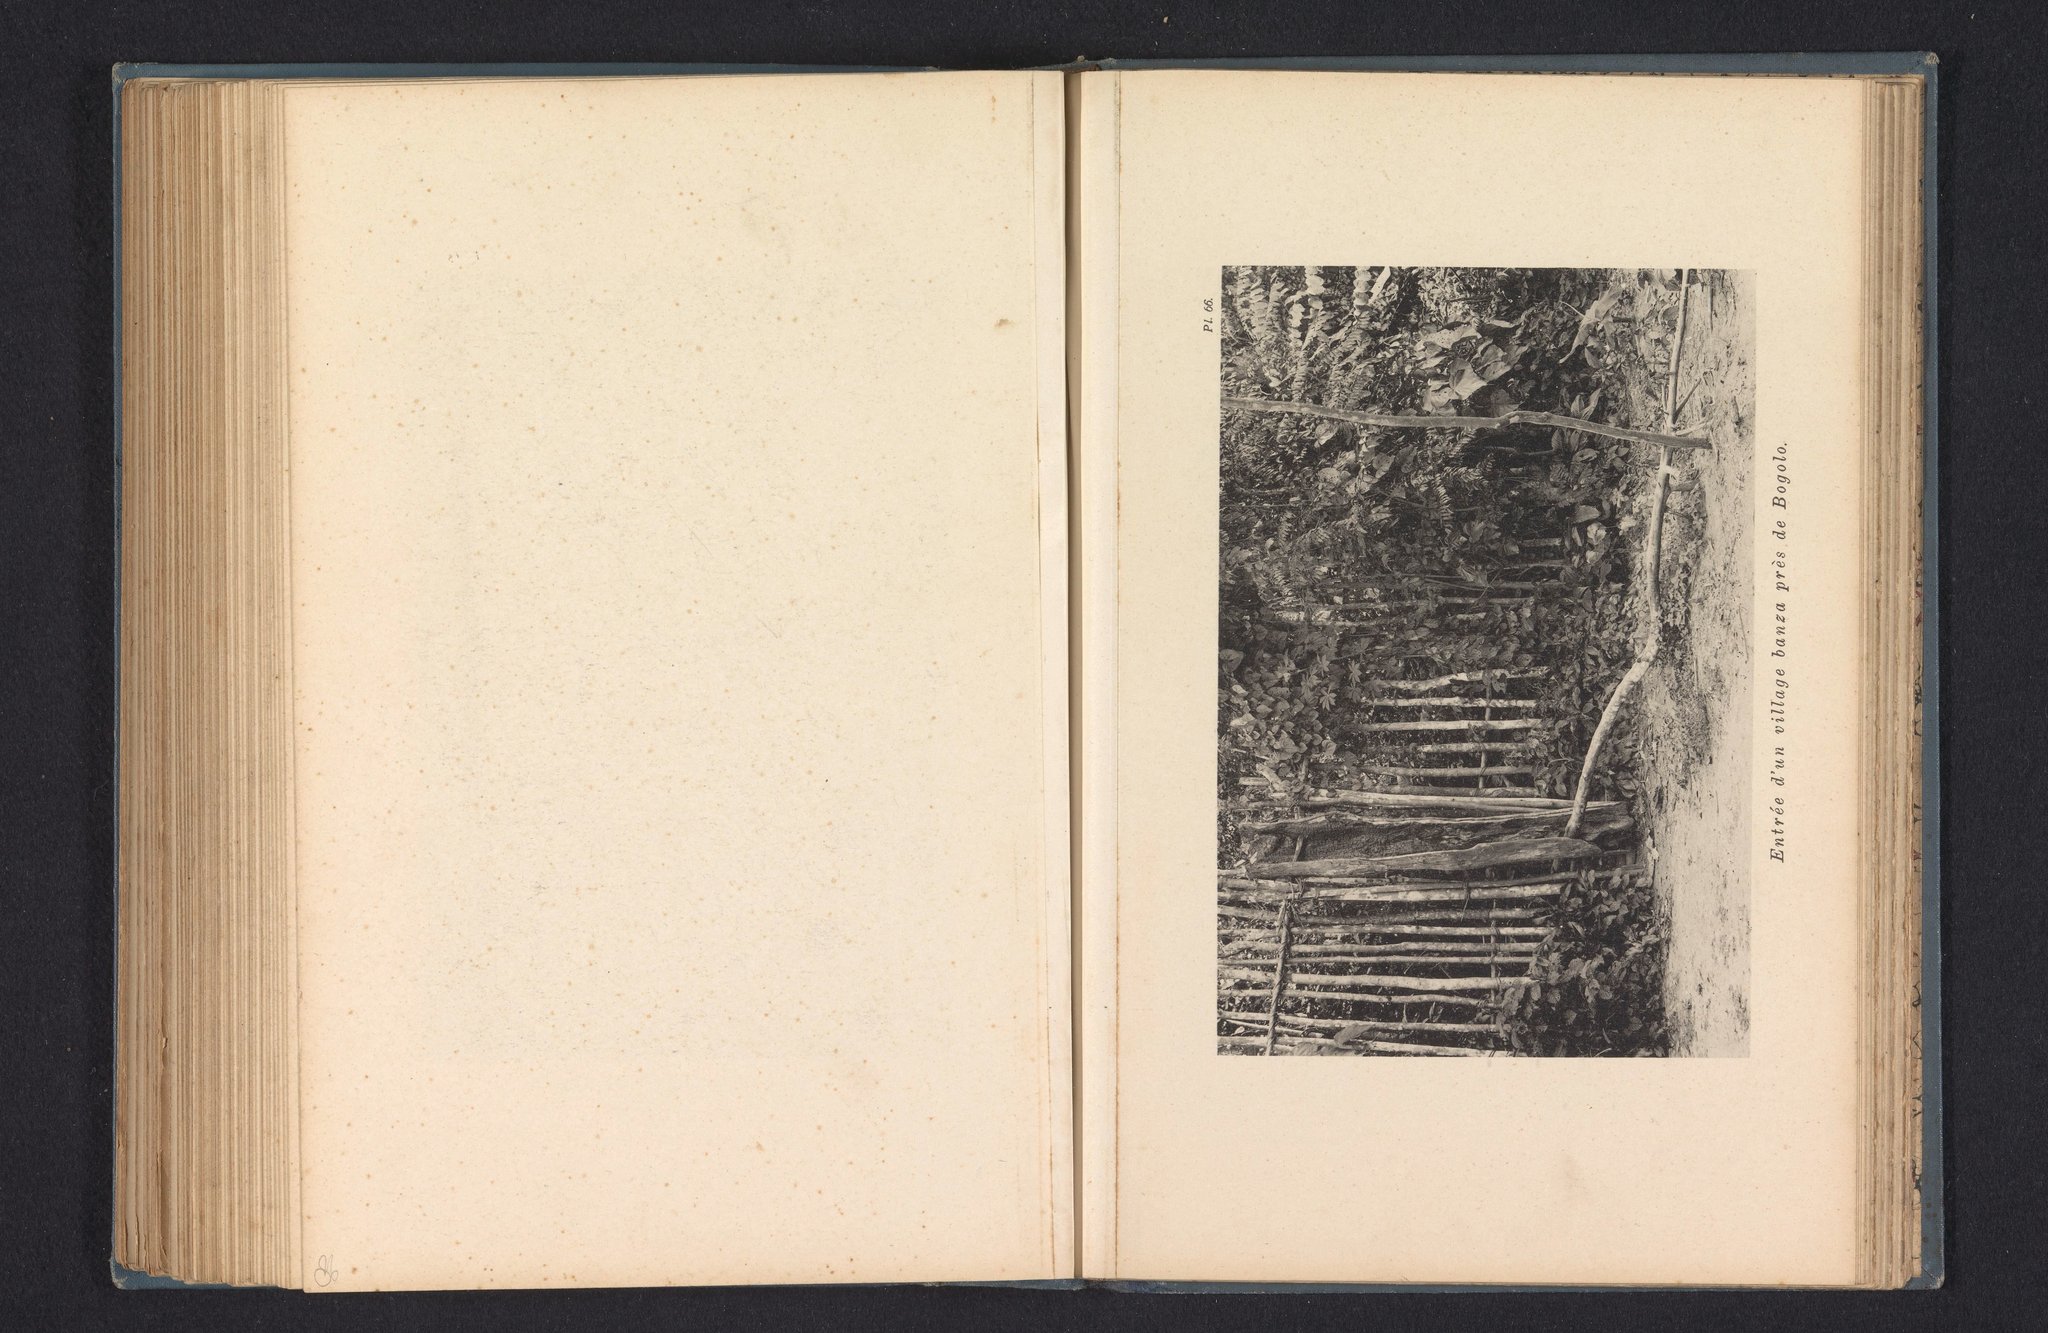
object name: page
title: Entrée d'un village banza près de Bogolo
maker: franz thonner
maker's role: botanicus, ontdekkingsreiziger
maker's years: 1863-1928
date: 1896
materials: paper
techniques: photograph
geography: congo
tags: fence, wall, paling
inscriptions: number: ‘Pl. 66.’